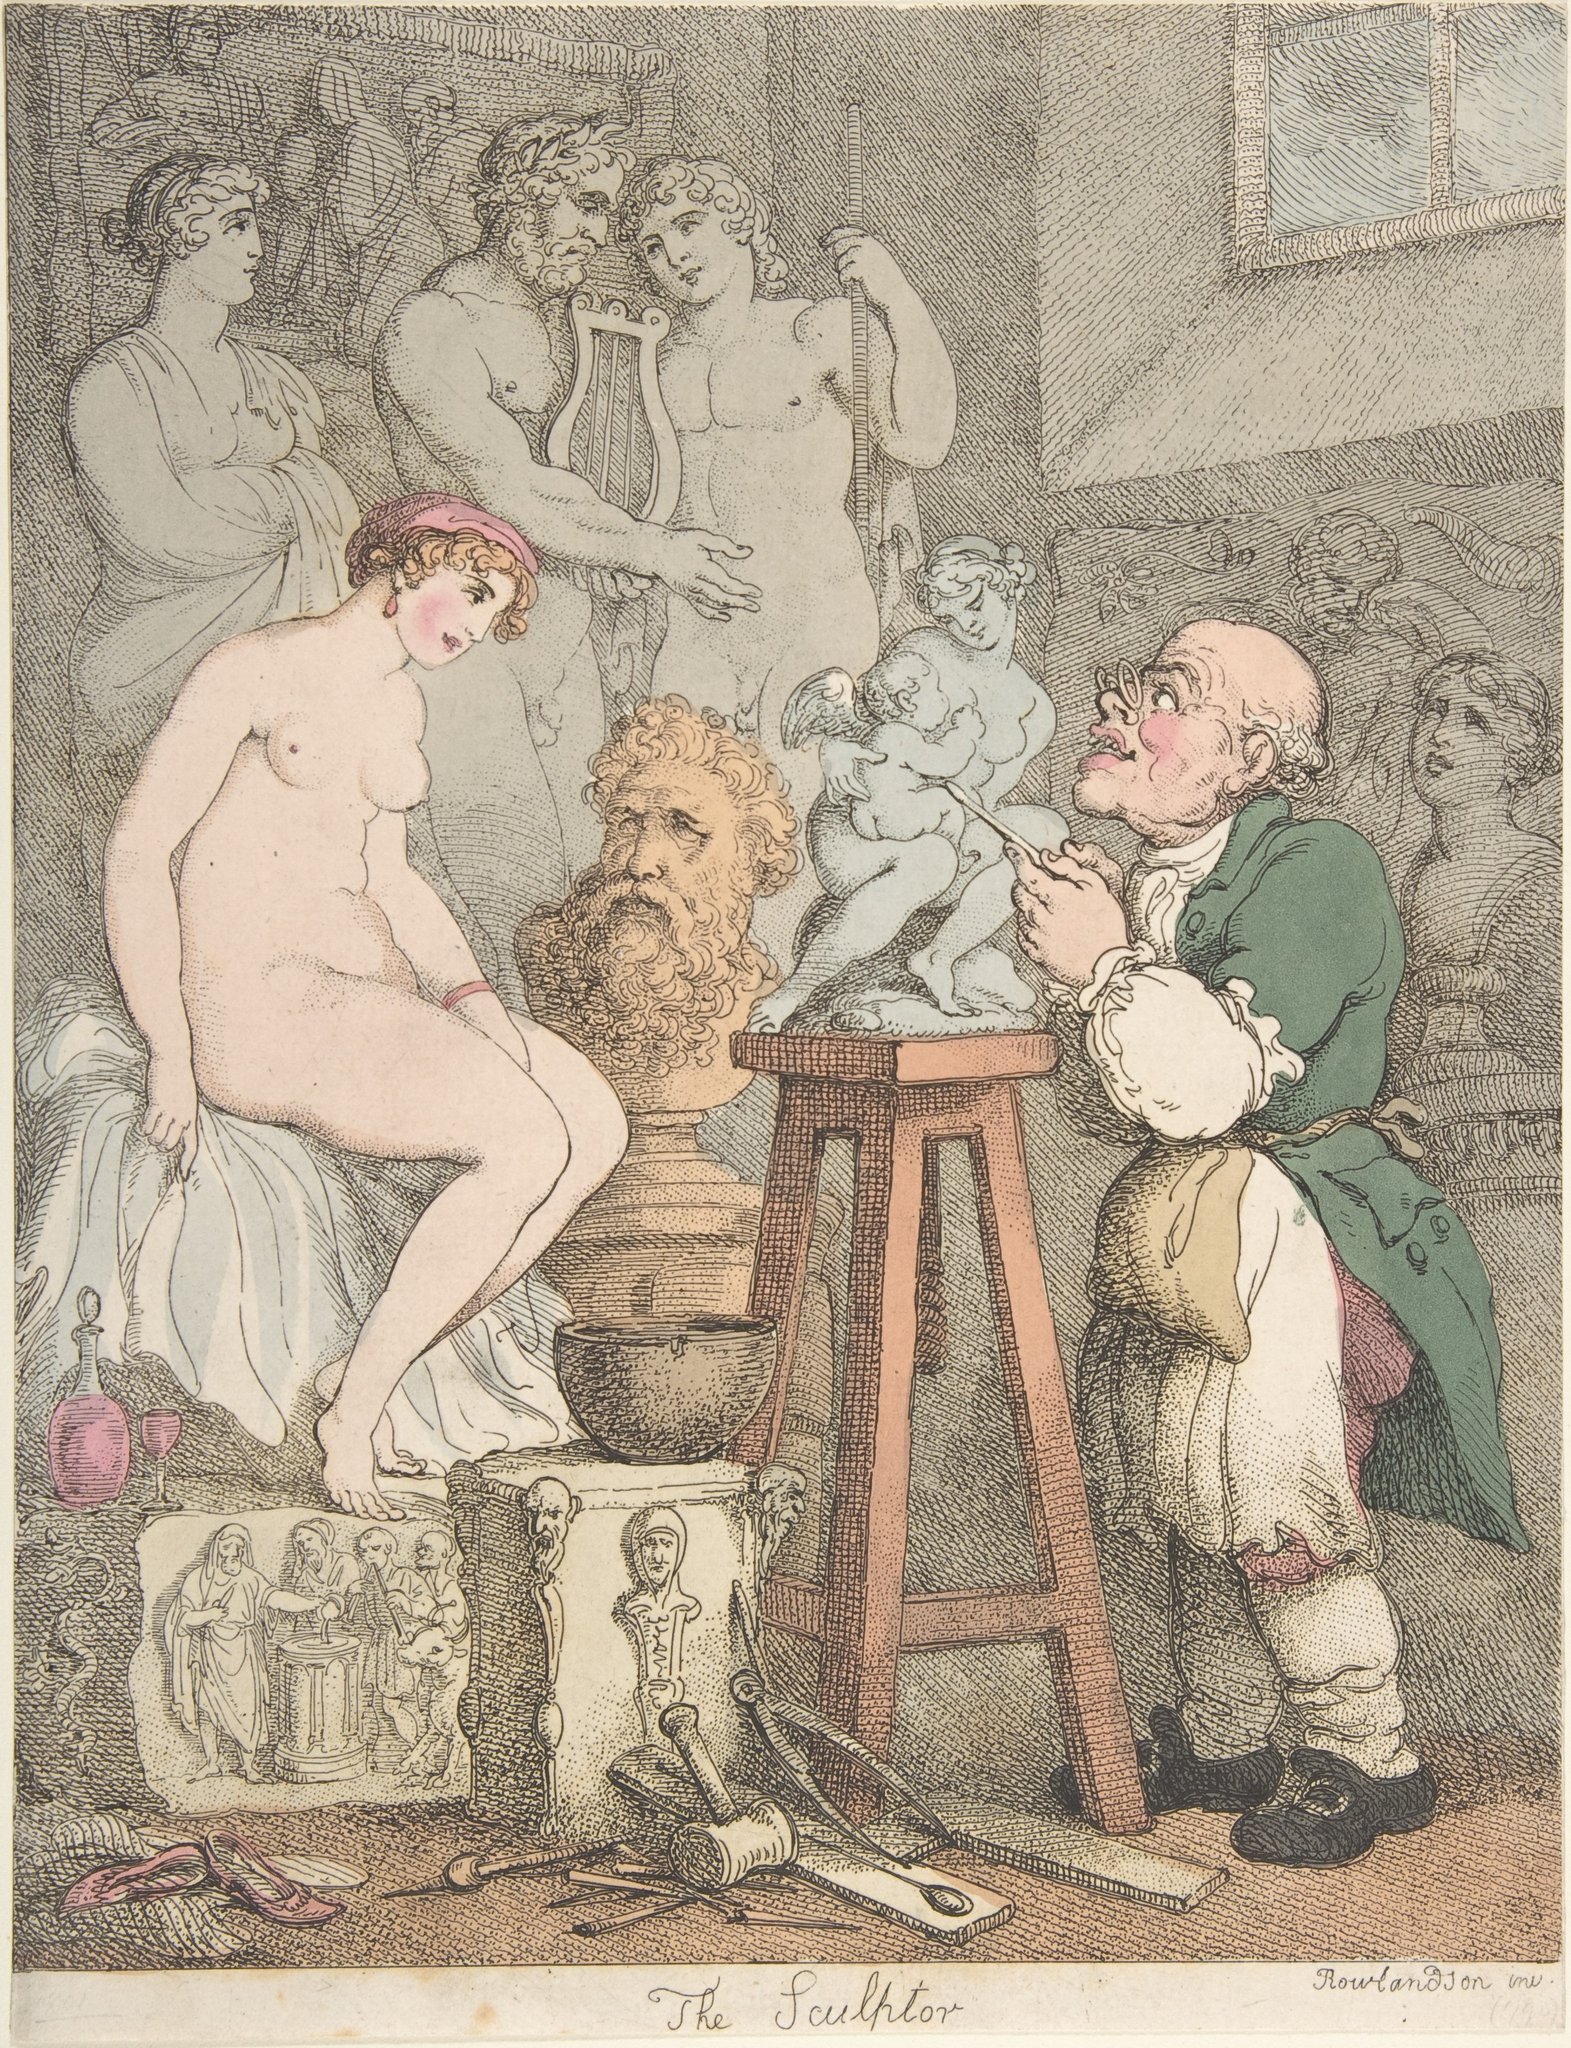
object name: print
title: The Sculptor [Preparations for the Academy, Old Joseph Nollekens and his Venus]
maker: thomas rowlandson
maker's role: artist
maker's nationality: british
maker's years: 1757-1827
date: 1800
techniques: etching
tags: sculpture,men,male nudes,venus